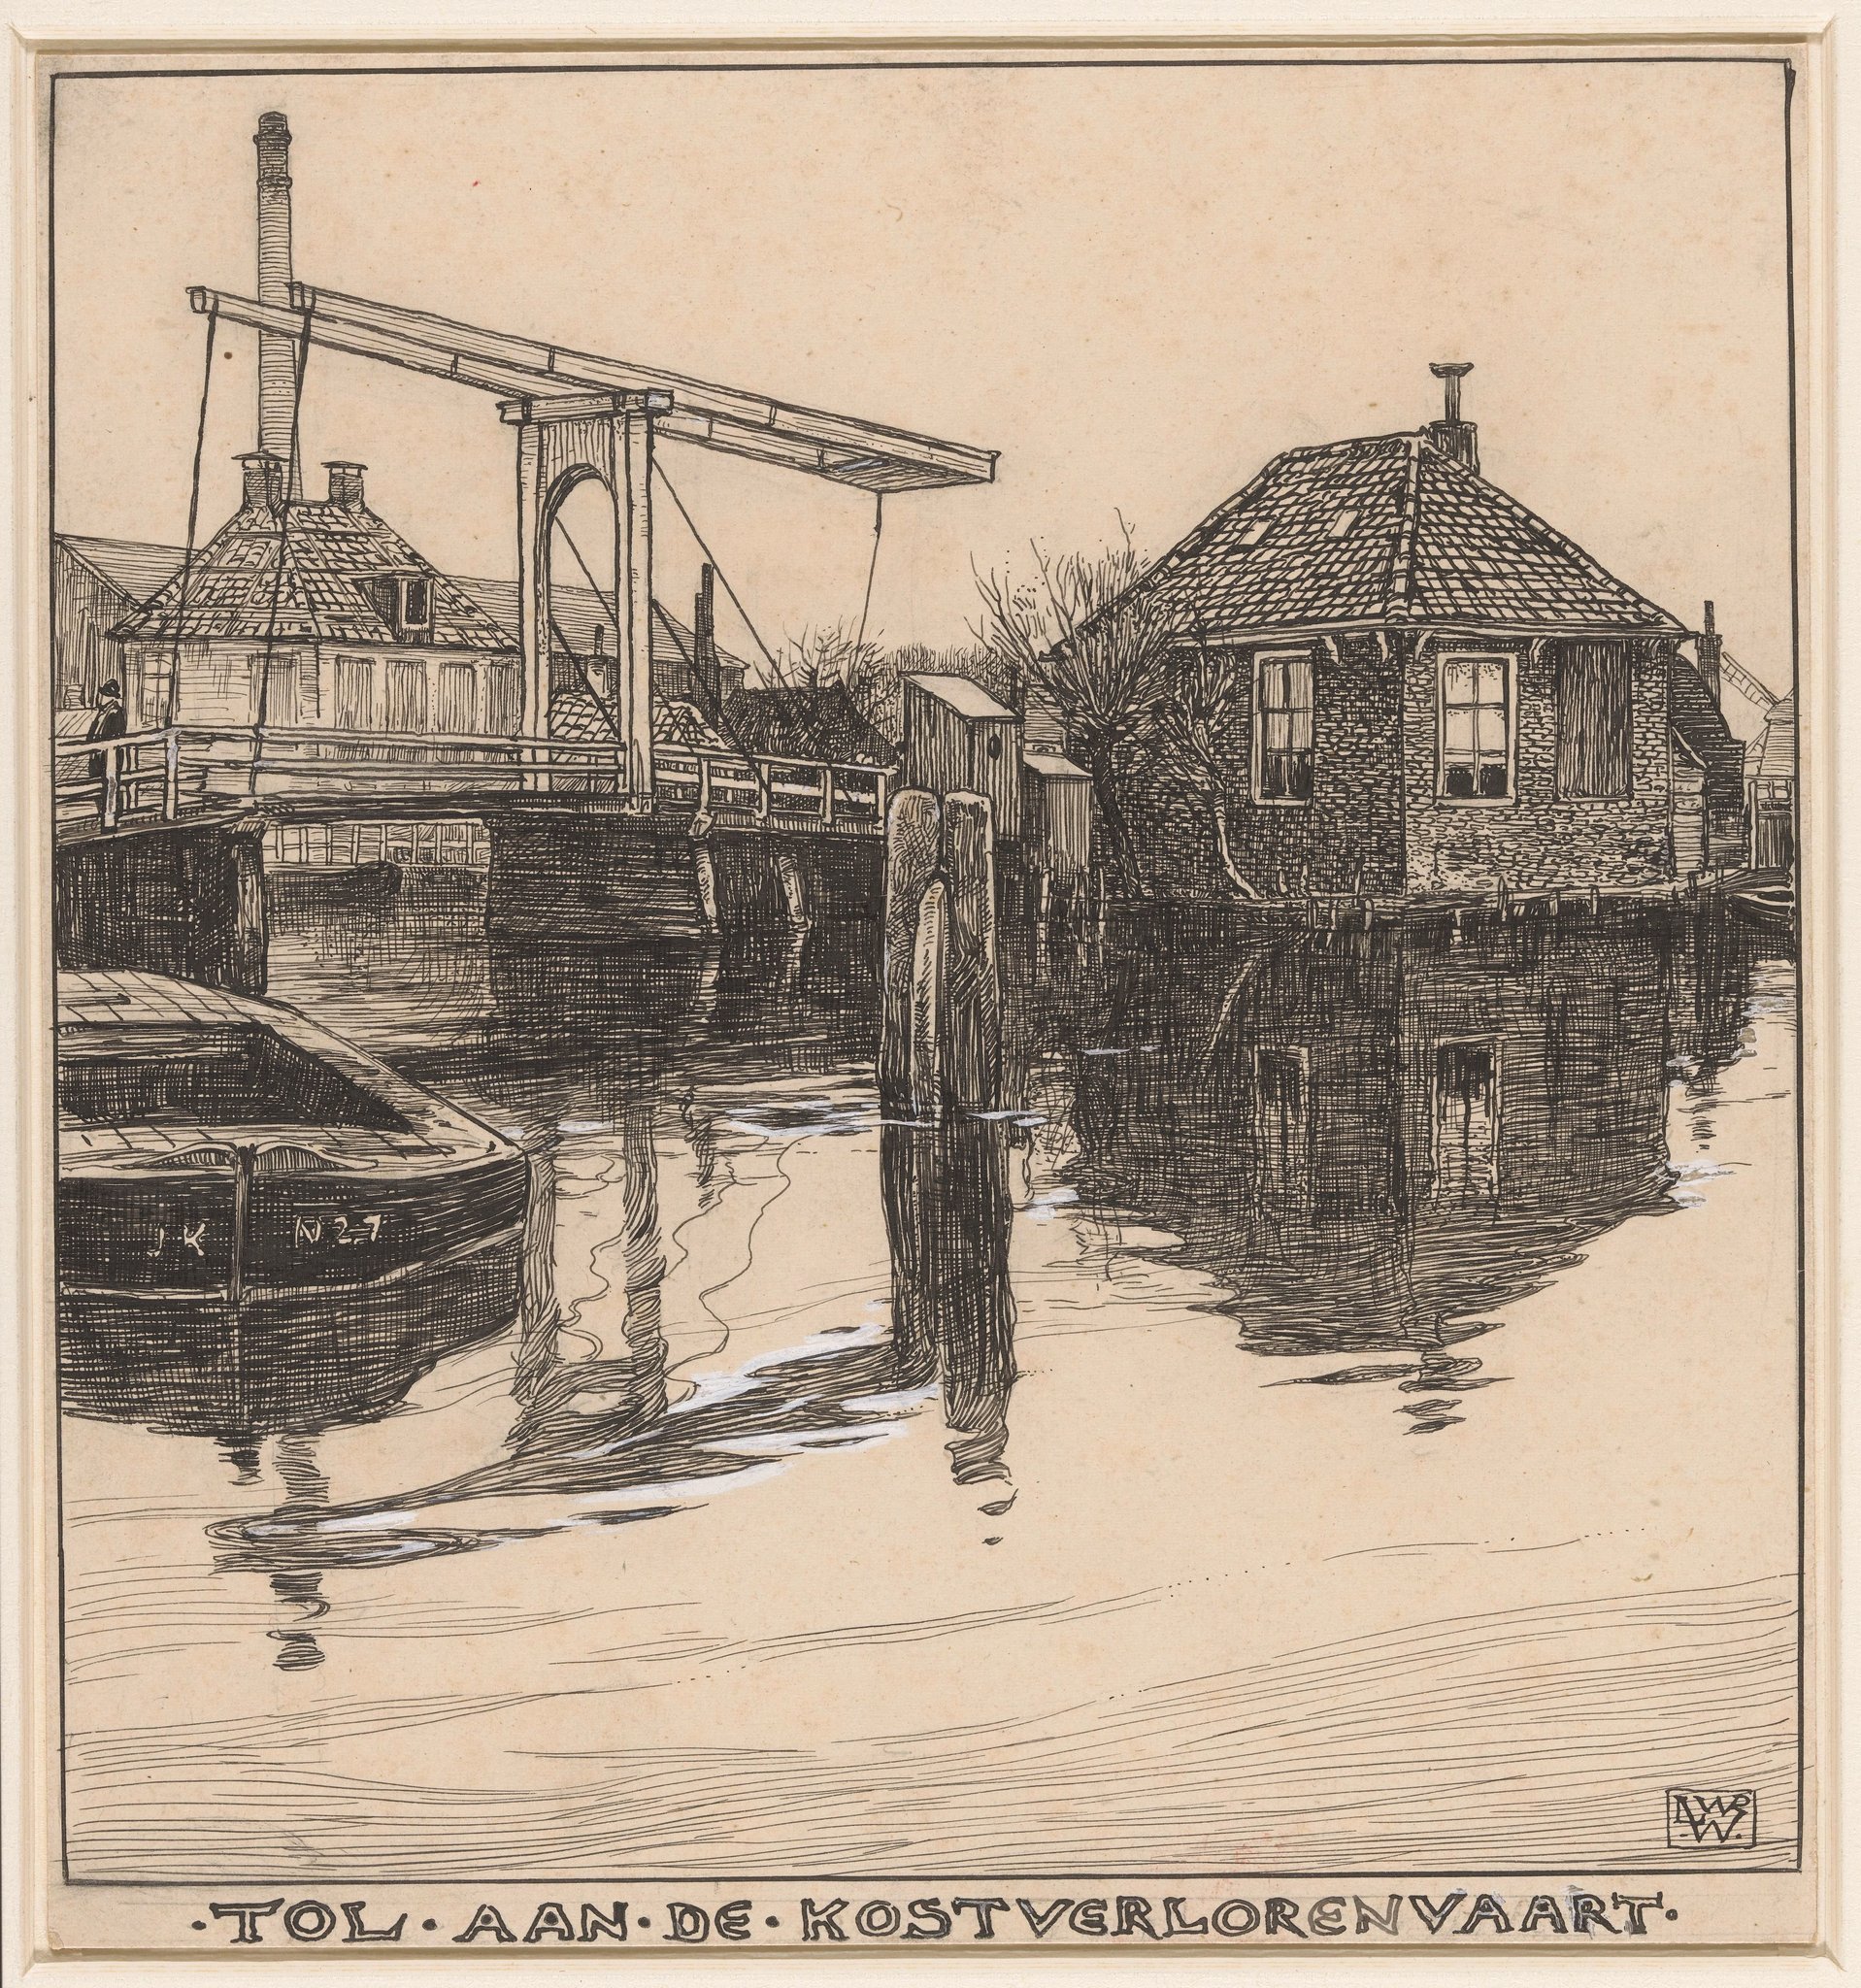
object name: drawing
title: Tol aan de Kostverlorenvaart te Amsterdam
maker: willem wenckebach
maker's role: designer, draughtsman, painter, print maker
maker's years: 1860-1937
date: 1870-1926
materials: cardboard, paint, ink, pencil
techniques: pen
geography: amsterdam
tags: canal